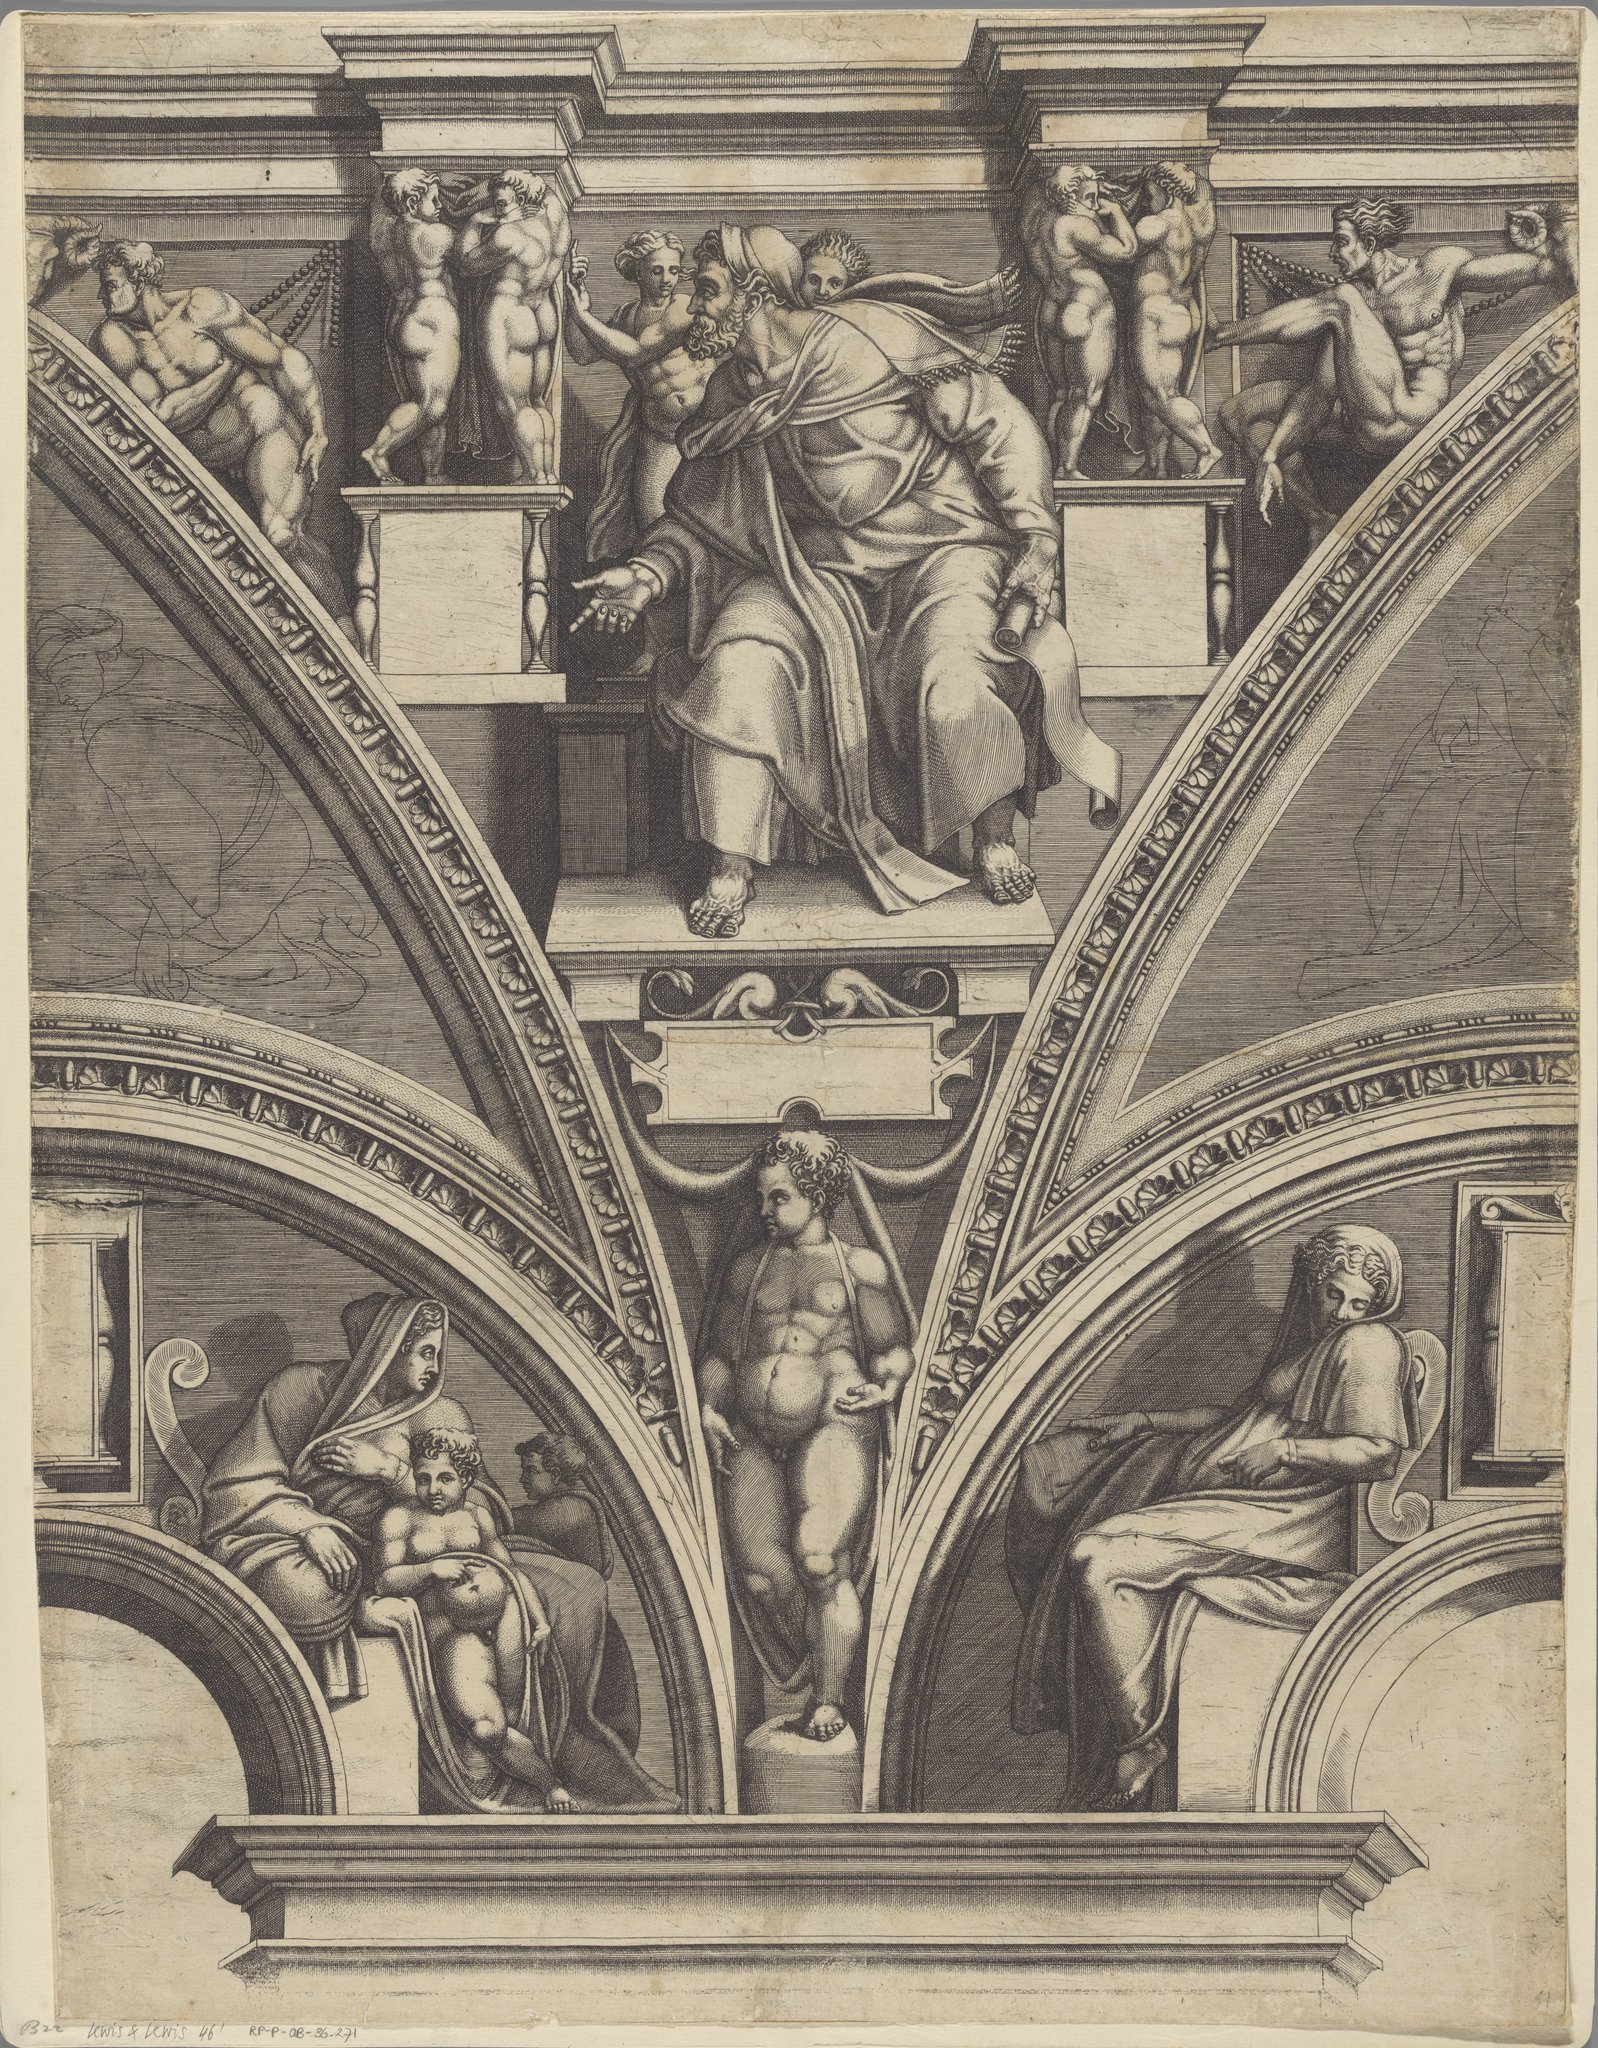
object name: print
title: Profeet Ezechiël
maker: giorgio ghisi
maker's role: print maker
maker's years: 1520-1582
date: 1530-1582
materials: paper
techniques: engraving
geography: italy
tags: prophets (after the babylonian captivity), the book of ezekiel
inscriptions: collector's mark: Lugt 240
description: Prent uit een reeks van 6 prenten naar de schilderingen in de lunetten boven de ramen in de Sixtijnse Kapel door Michelangelo.